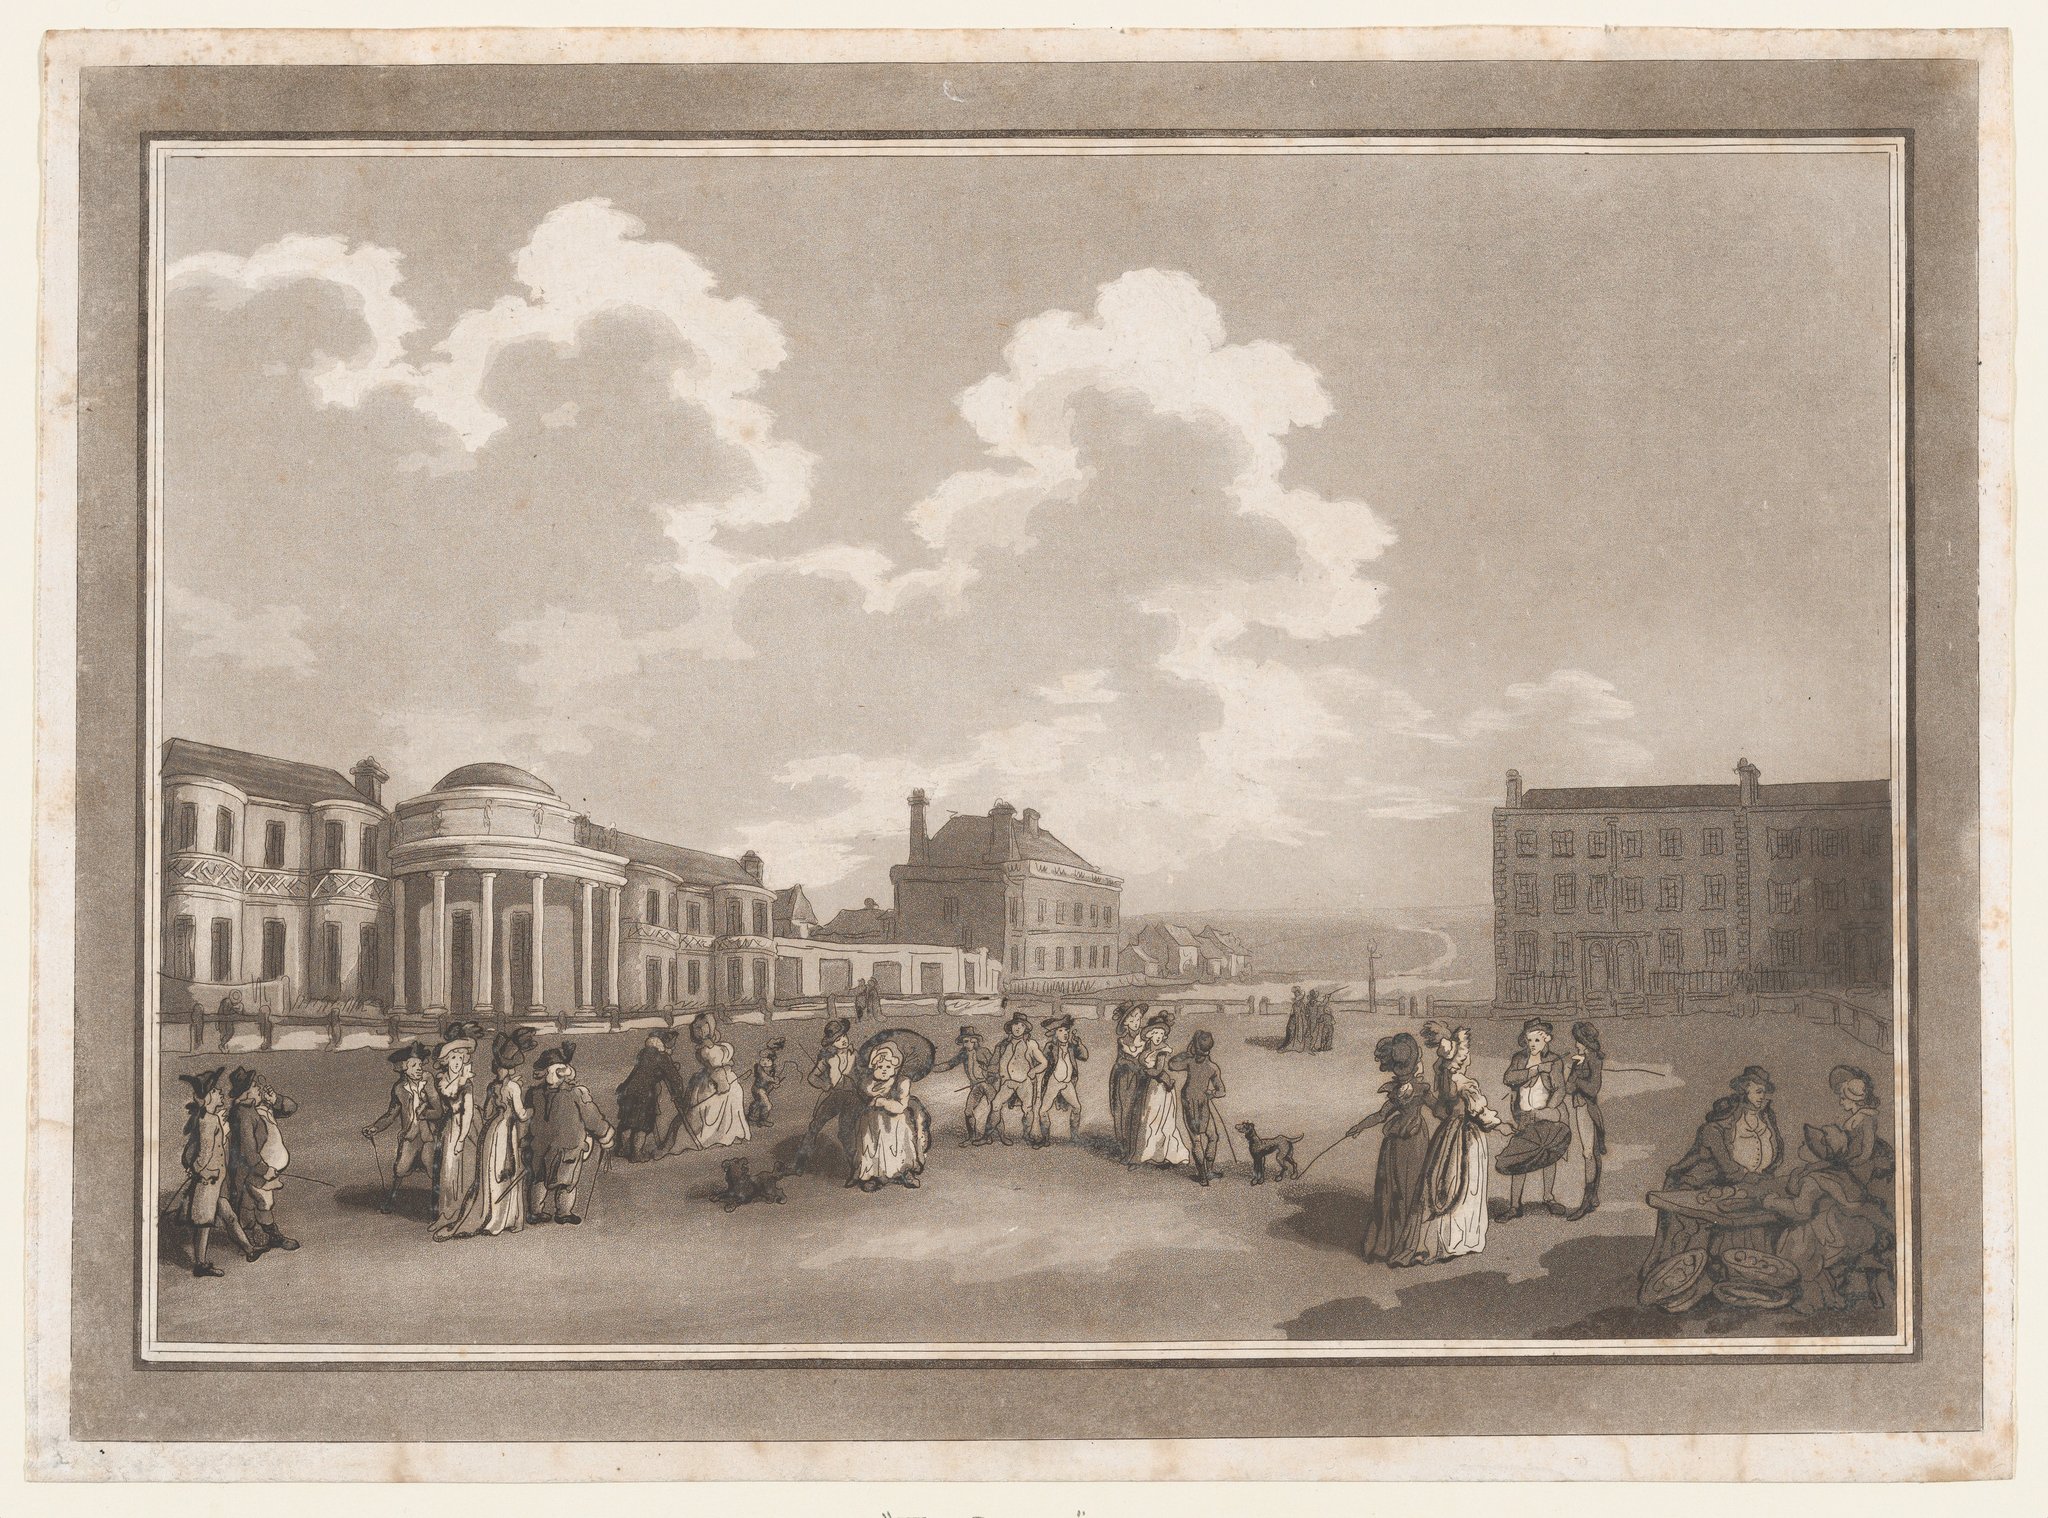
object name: print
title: The Steine (An Excursion to Brighthelmstone)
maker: thomas rowlandson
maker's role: artist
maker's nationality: british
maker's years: 1757-1827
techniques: aquatint, etching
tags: buildings,men,women,walking,dogs